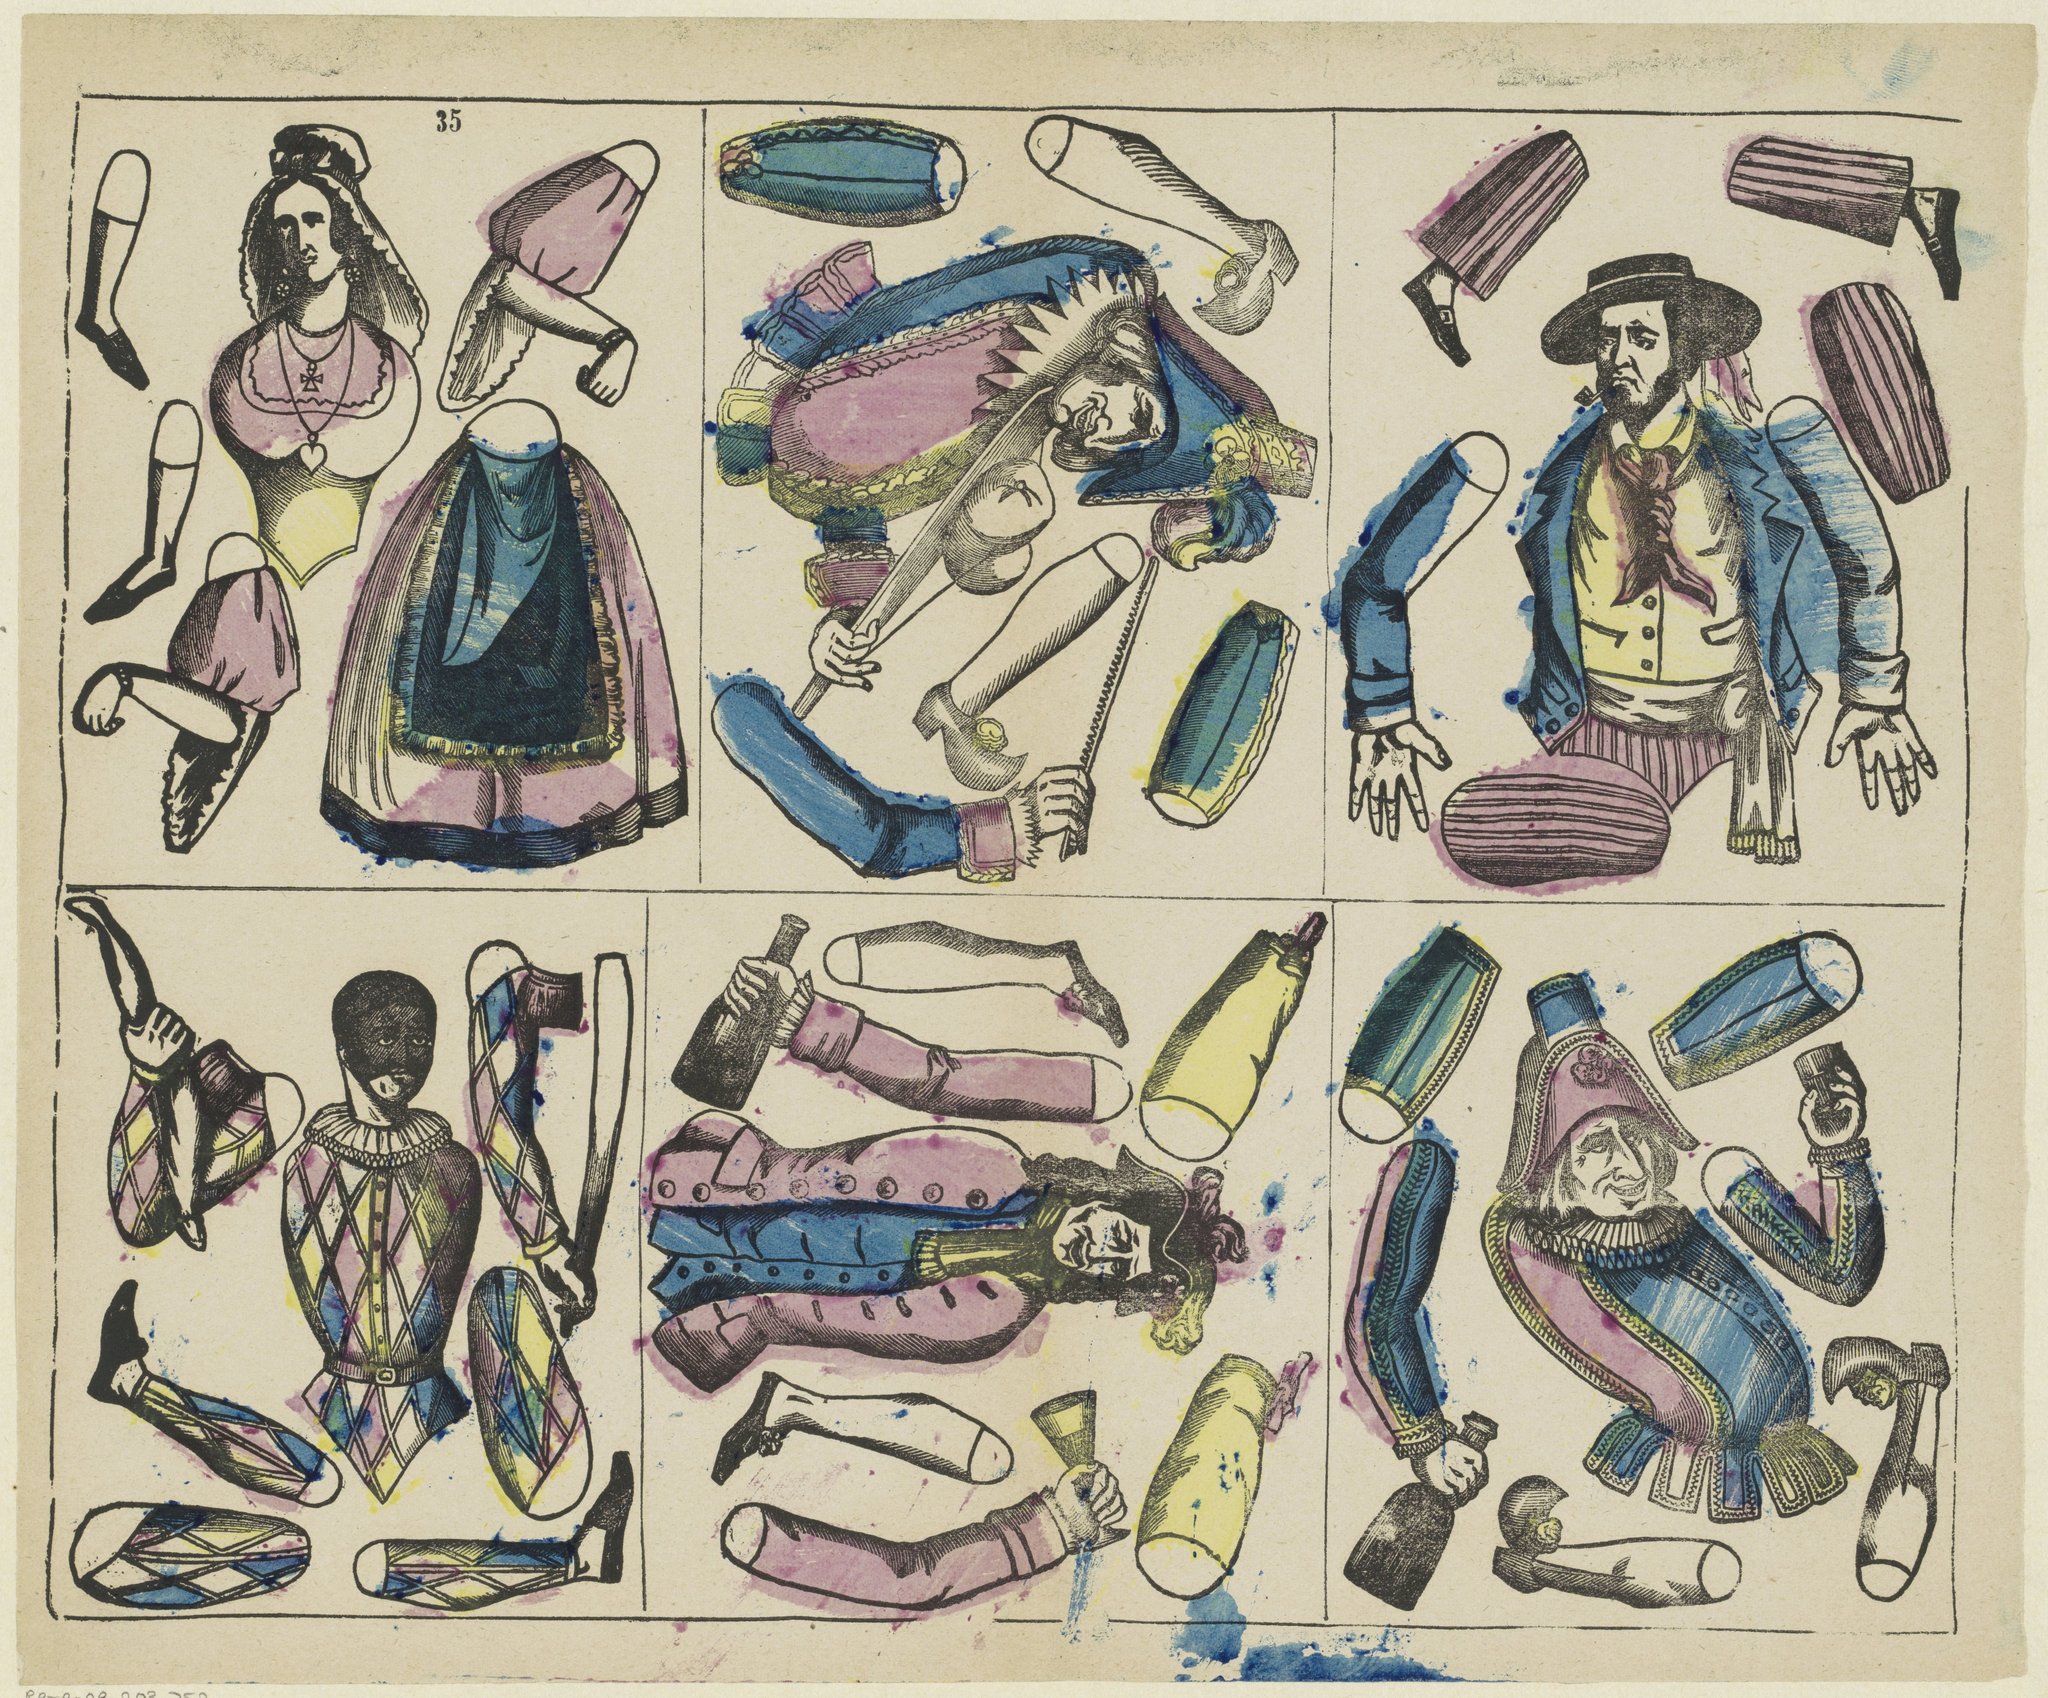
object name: pantin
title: Trekpoppen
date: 1827-1894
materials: paper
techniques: colour, letterpress printing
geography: schaarbeek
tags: types in 'commedia dell'arte', puppet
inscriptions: collector's mark: Lugt 2760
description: Blad met 6 voorstellingen van verschillende trekpoppen om uit te knippen, van figuren uit de Commedia dell'arte. Genummerd linksboven: 35.